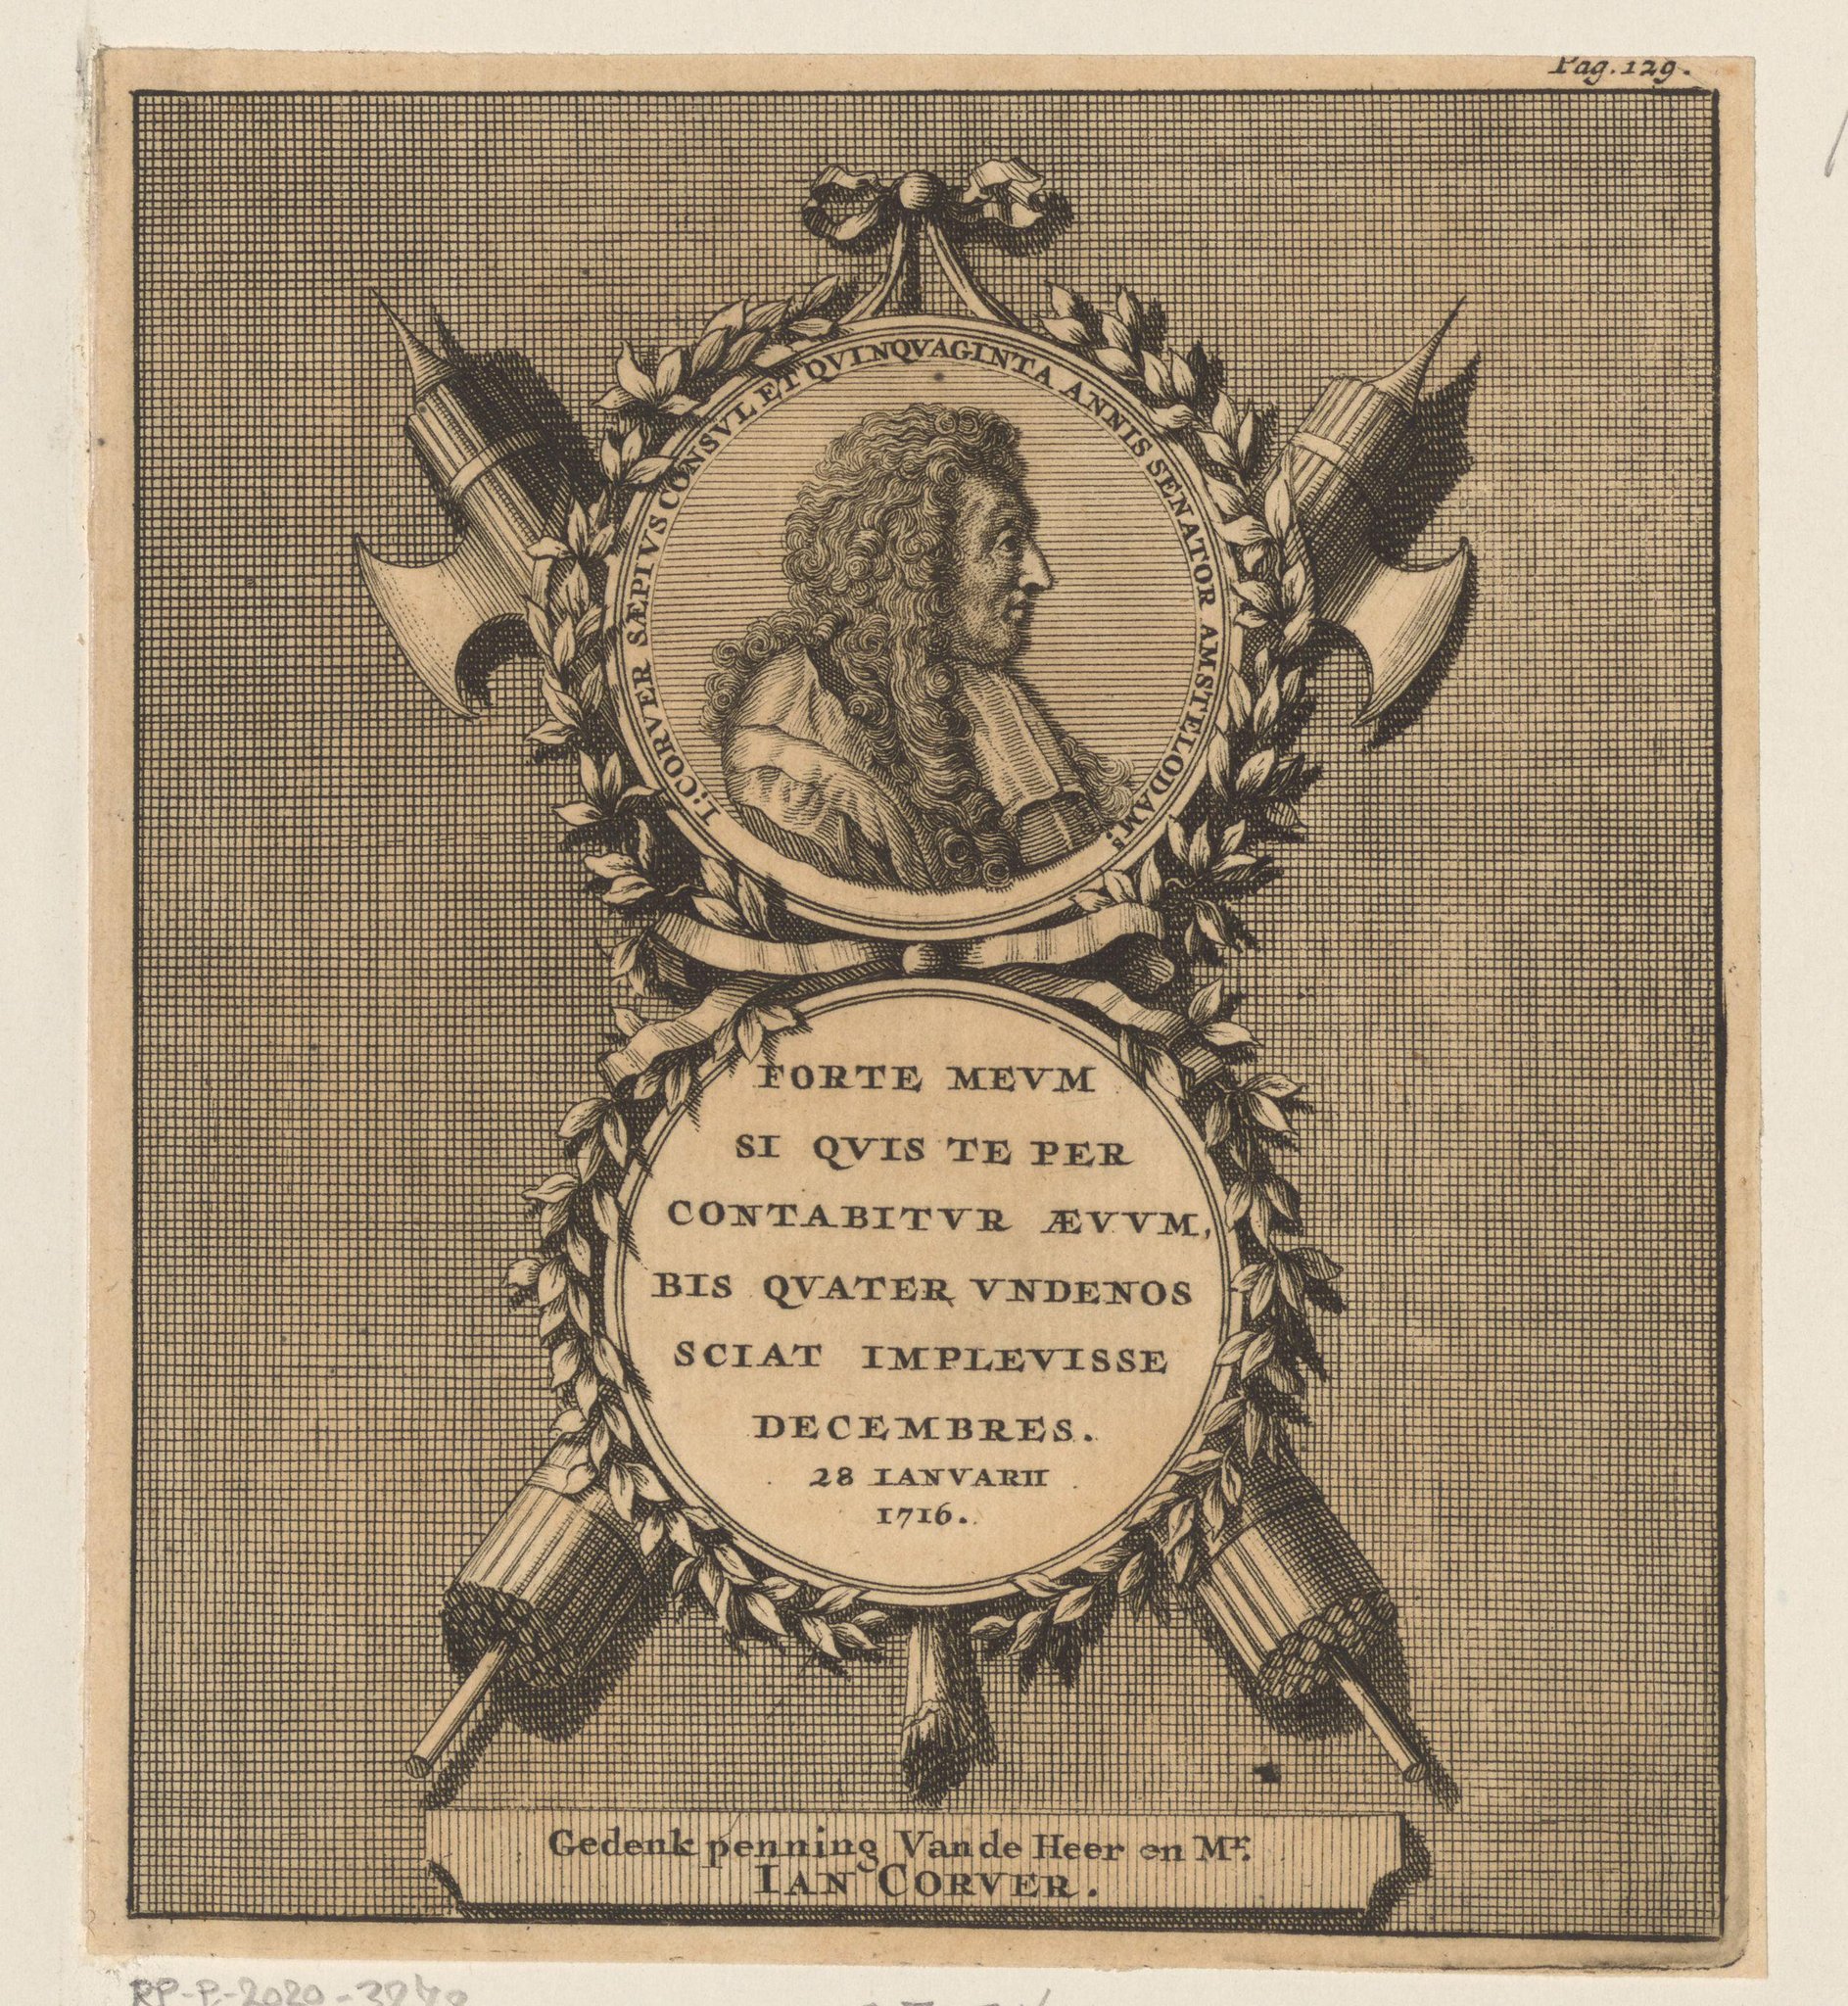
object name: print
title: Medaille met het portret van Joan Corver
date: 1716-1774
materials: paper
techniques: engraving, etching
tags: amsterdam, mayor, historical persons